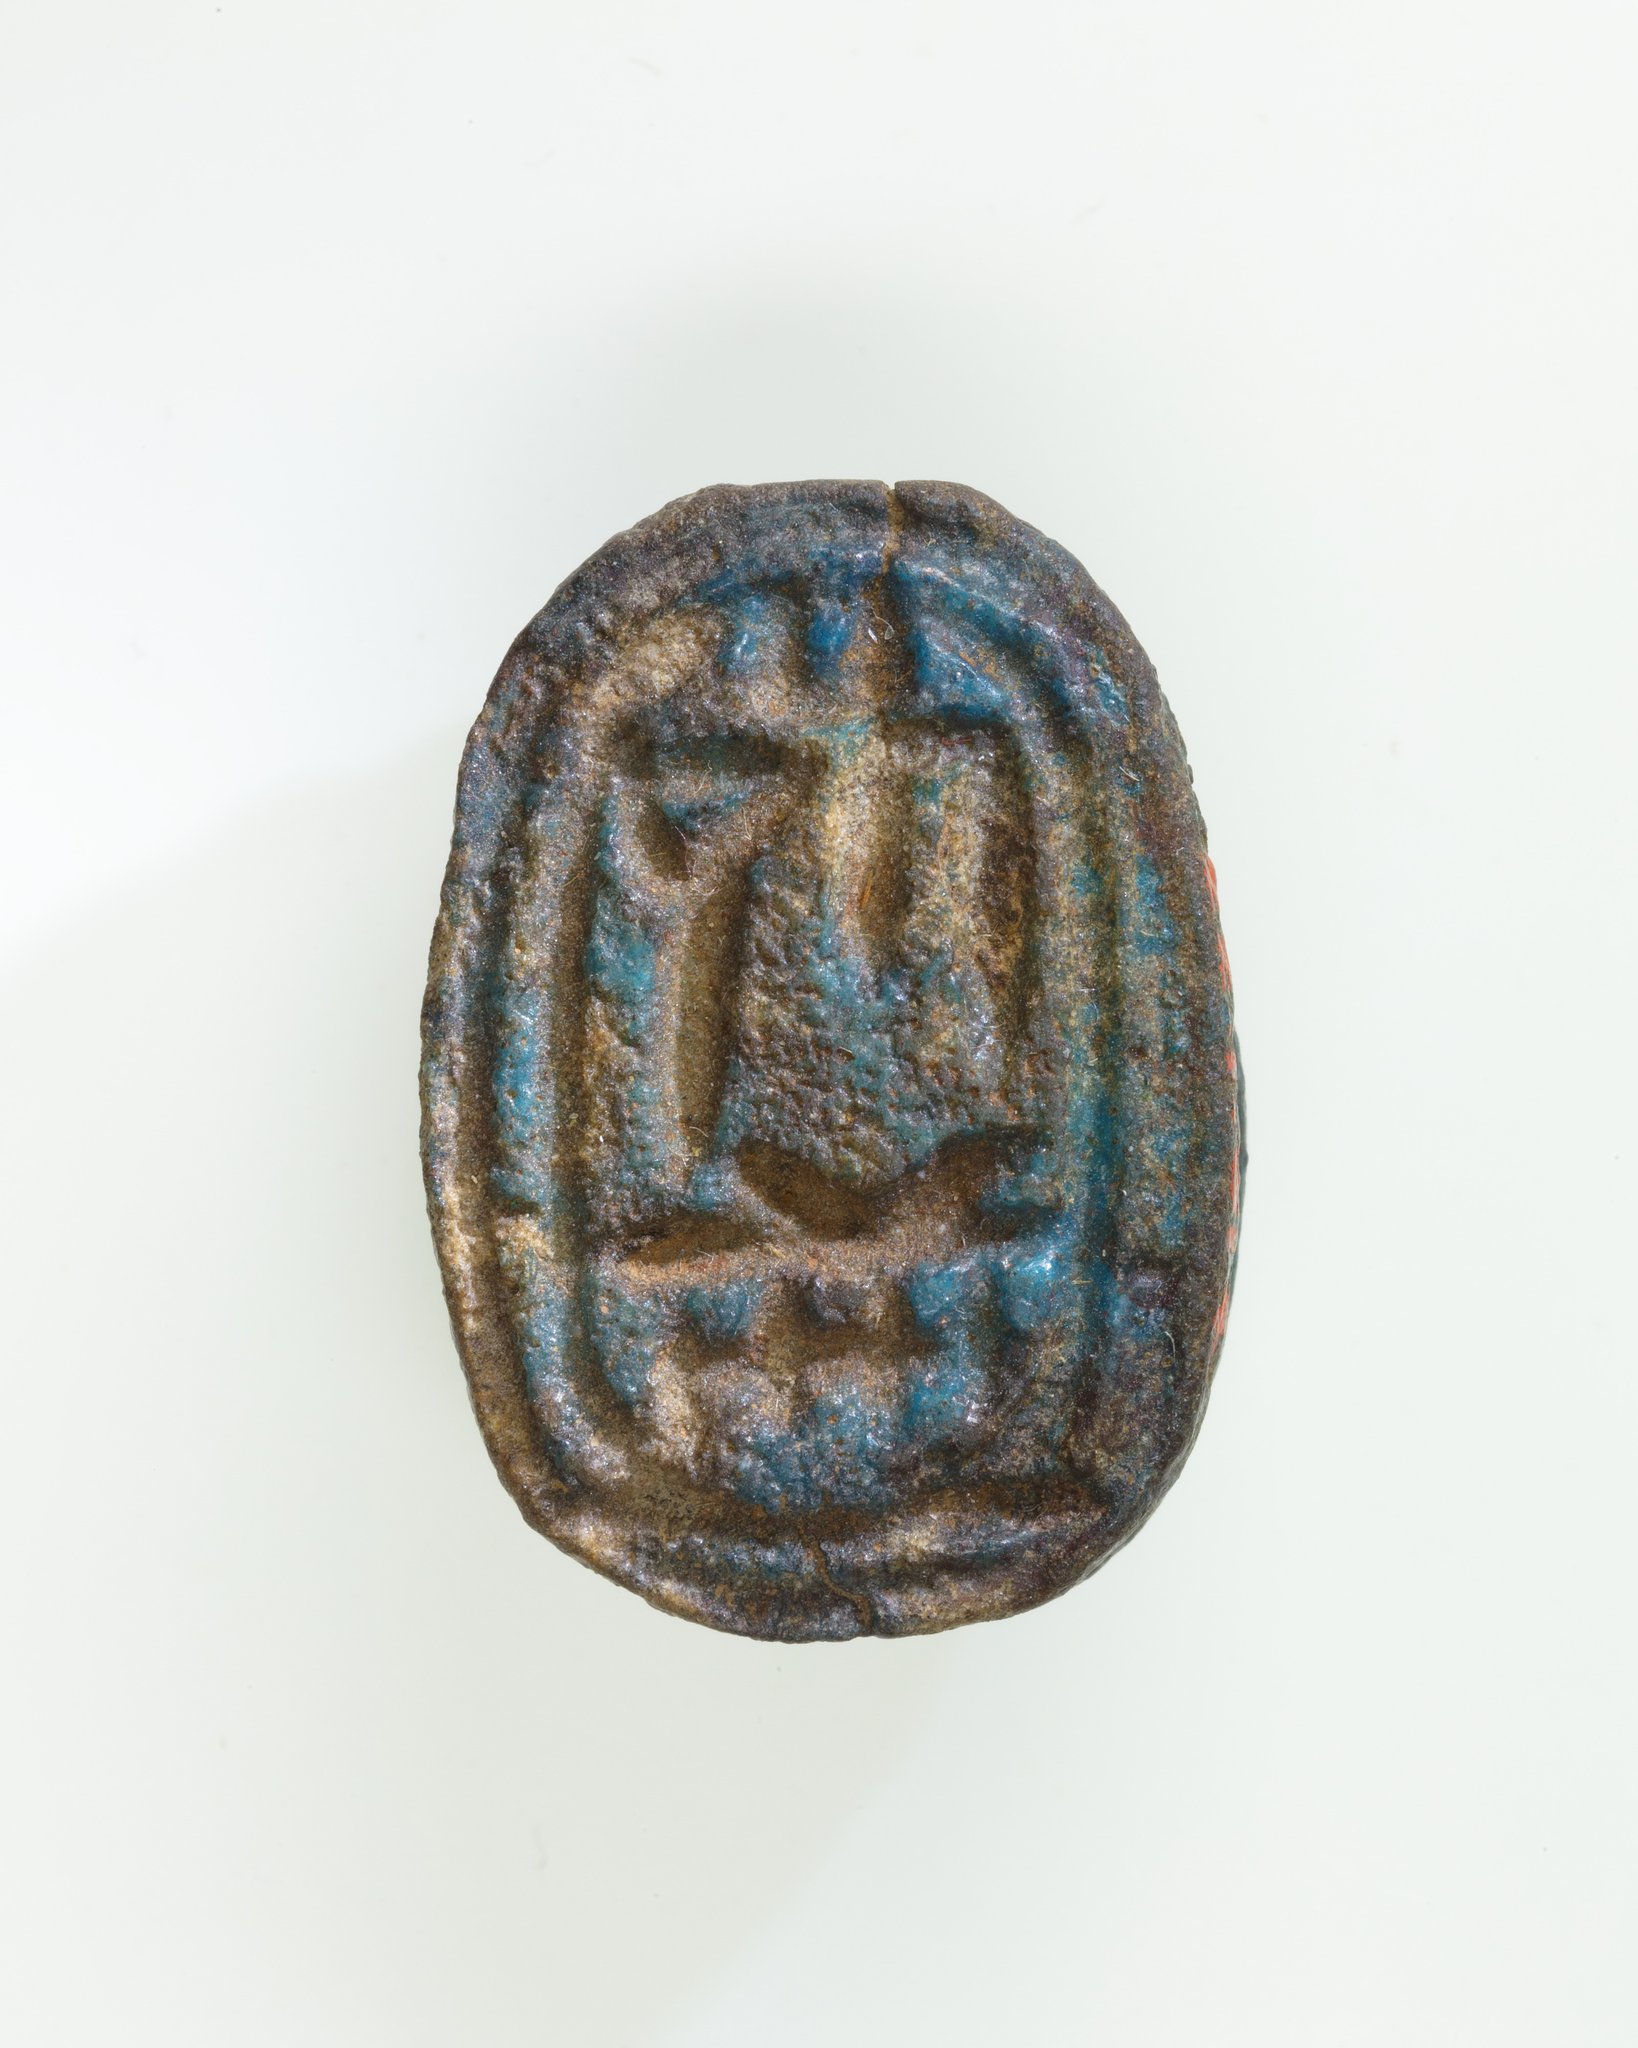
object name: scarab, sewadjenre, nebirierau i, royal, hieroglyph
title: Scarab of Nebirierau I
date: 1627-1601 BCE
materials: faience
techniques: glazing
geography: egypt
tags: scarabs